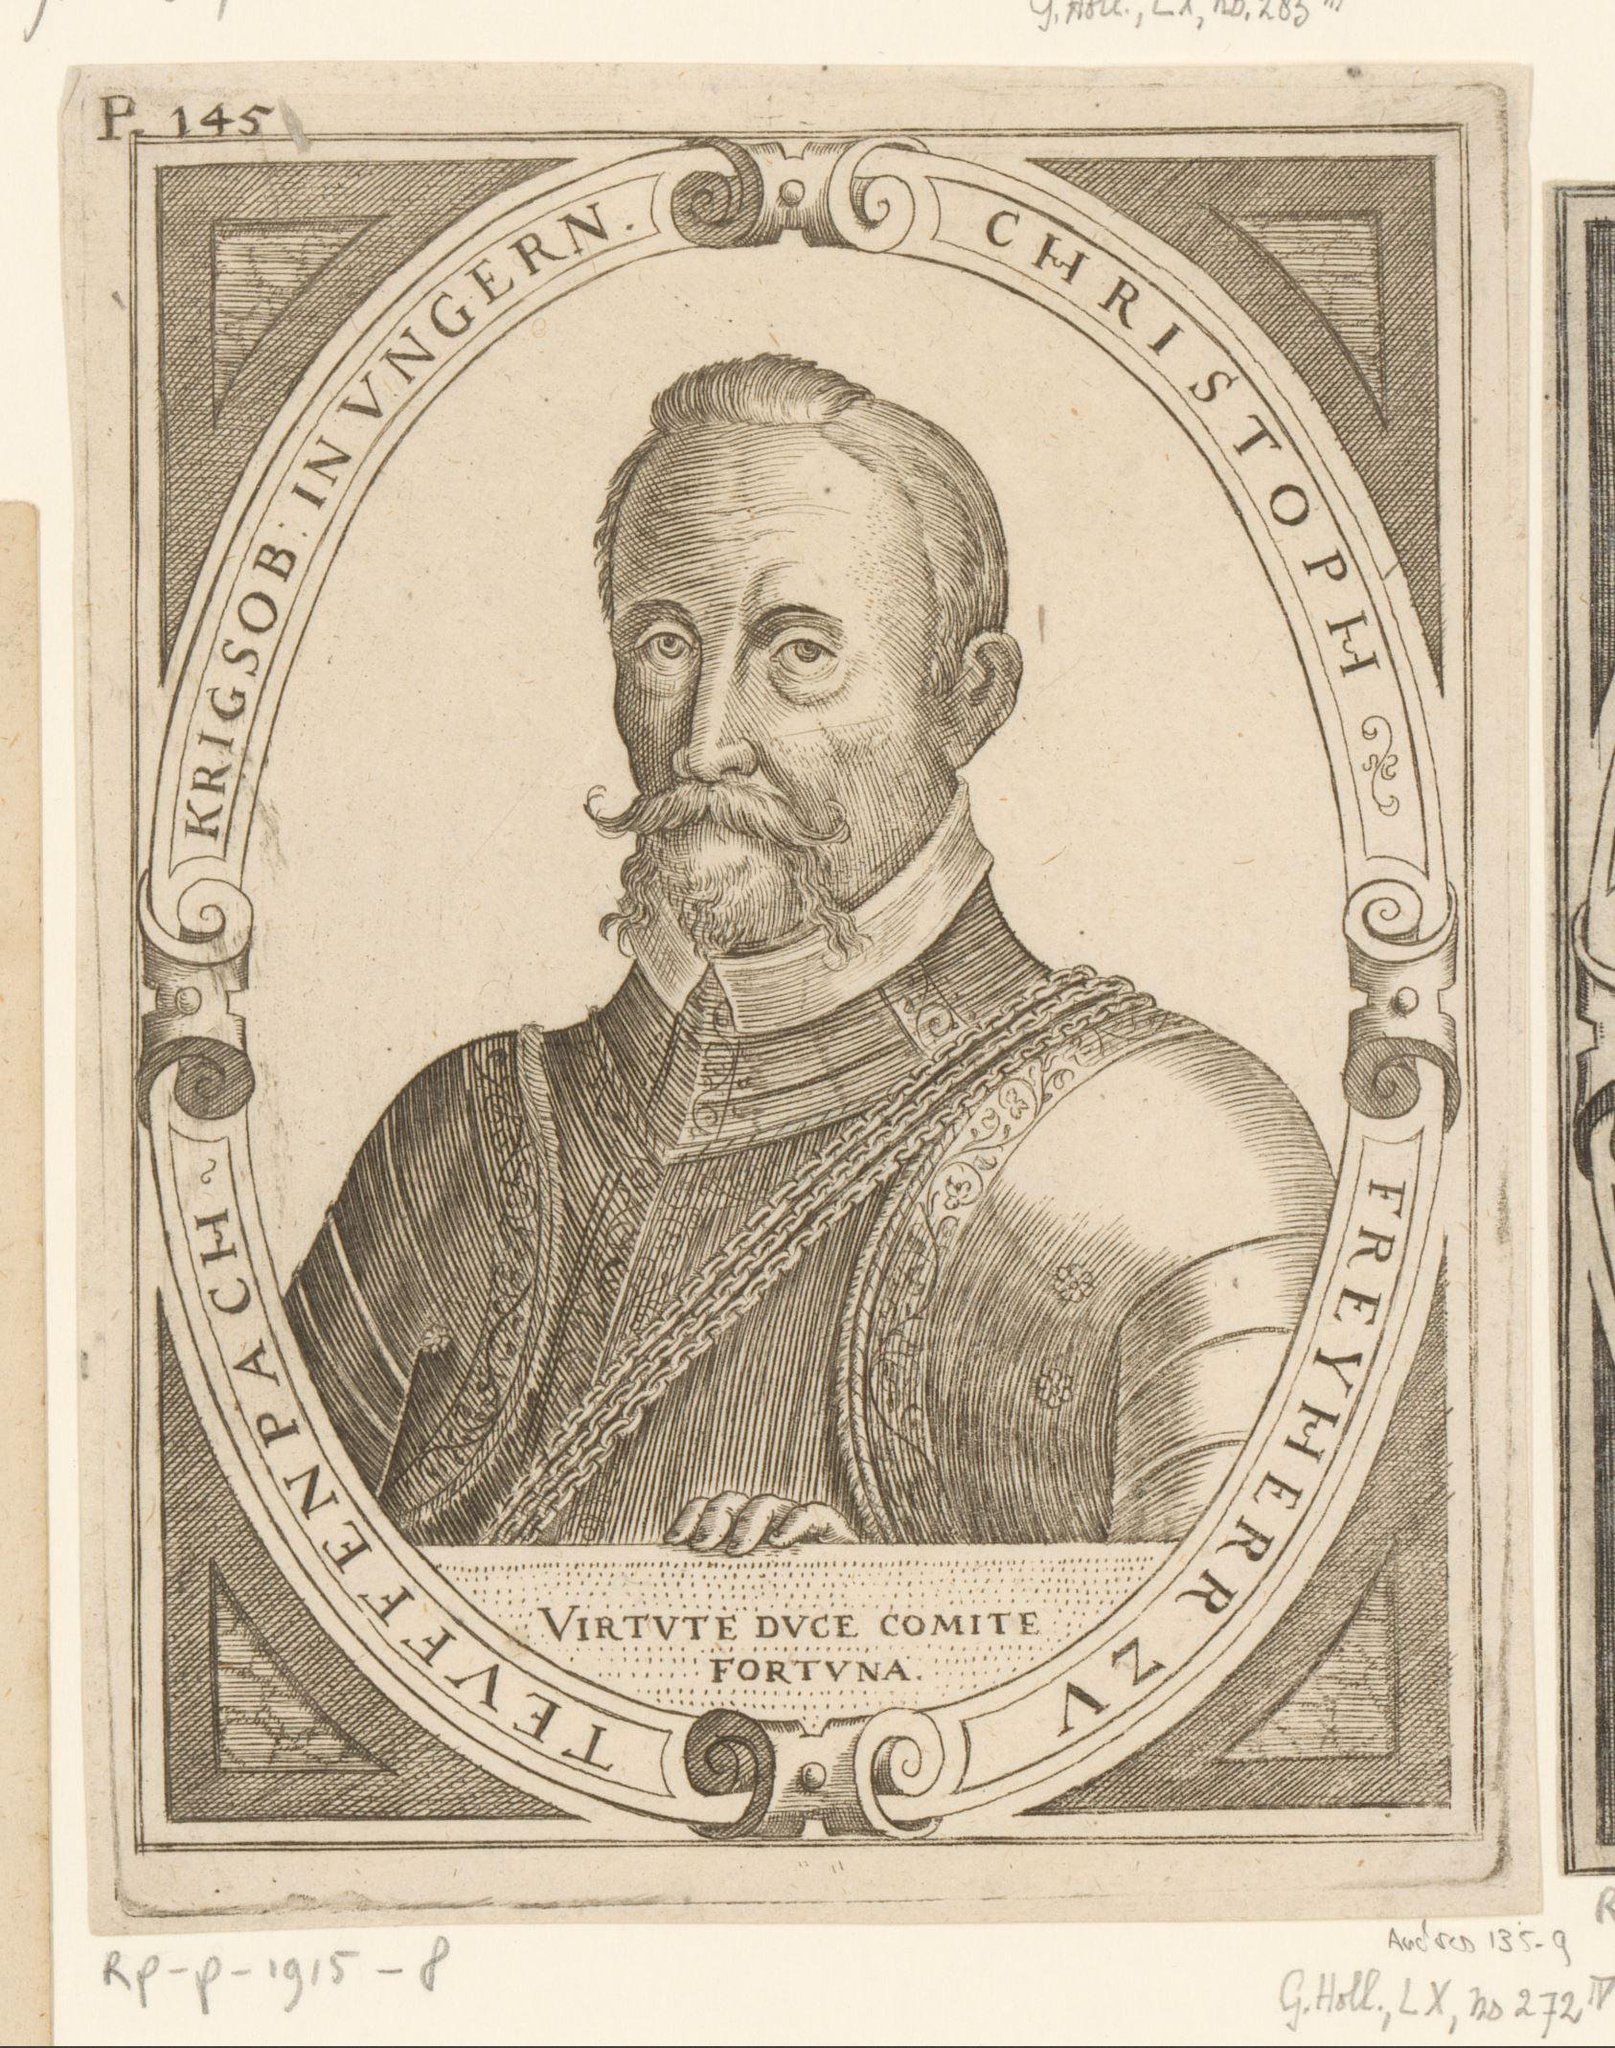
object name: print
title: Portret van Christoph von Teuffenpach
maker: hans sibmacher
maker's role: print maker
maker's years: -1611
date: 1590-1611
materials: paper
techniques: etching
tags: armour, historical persons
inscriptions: collector's mark: Lugt 2228, number: ‘P. 145’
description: Prent ook gebruikt in: Oretlius, Hieronymus. Chronologica (...). Neurenberg: Valentin Fuhrmann et. al., 1602-1665.